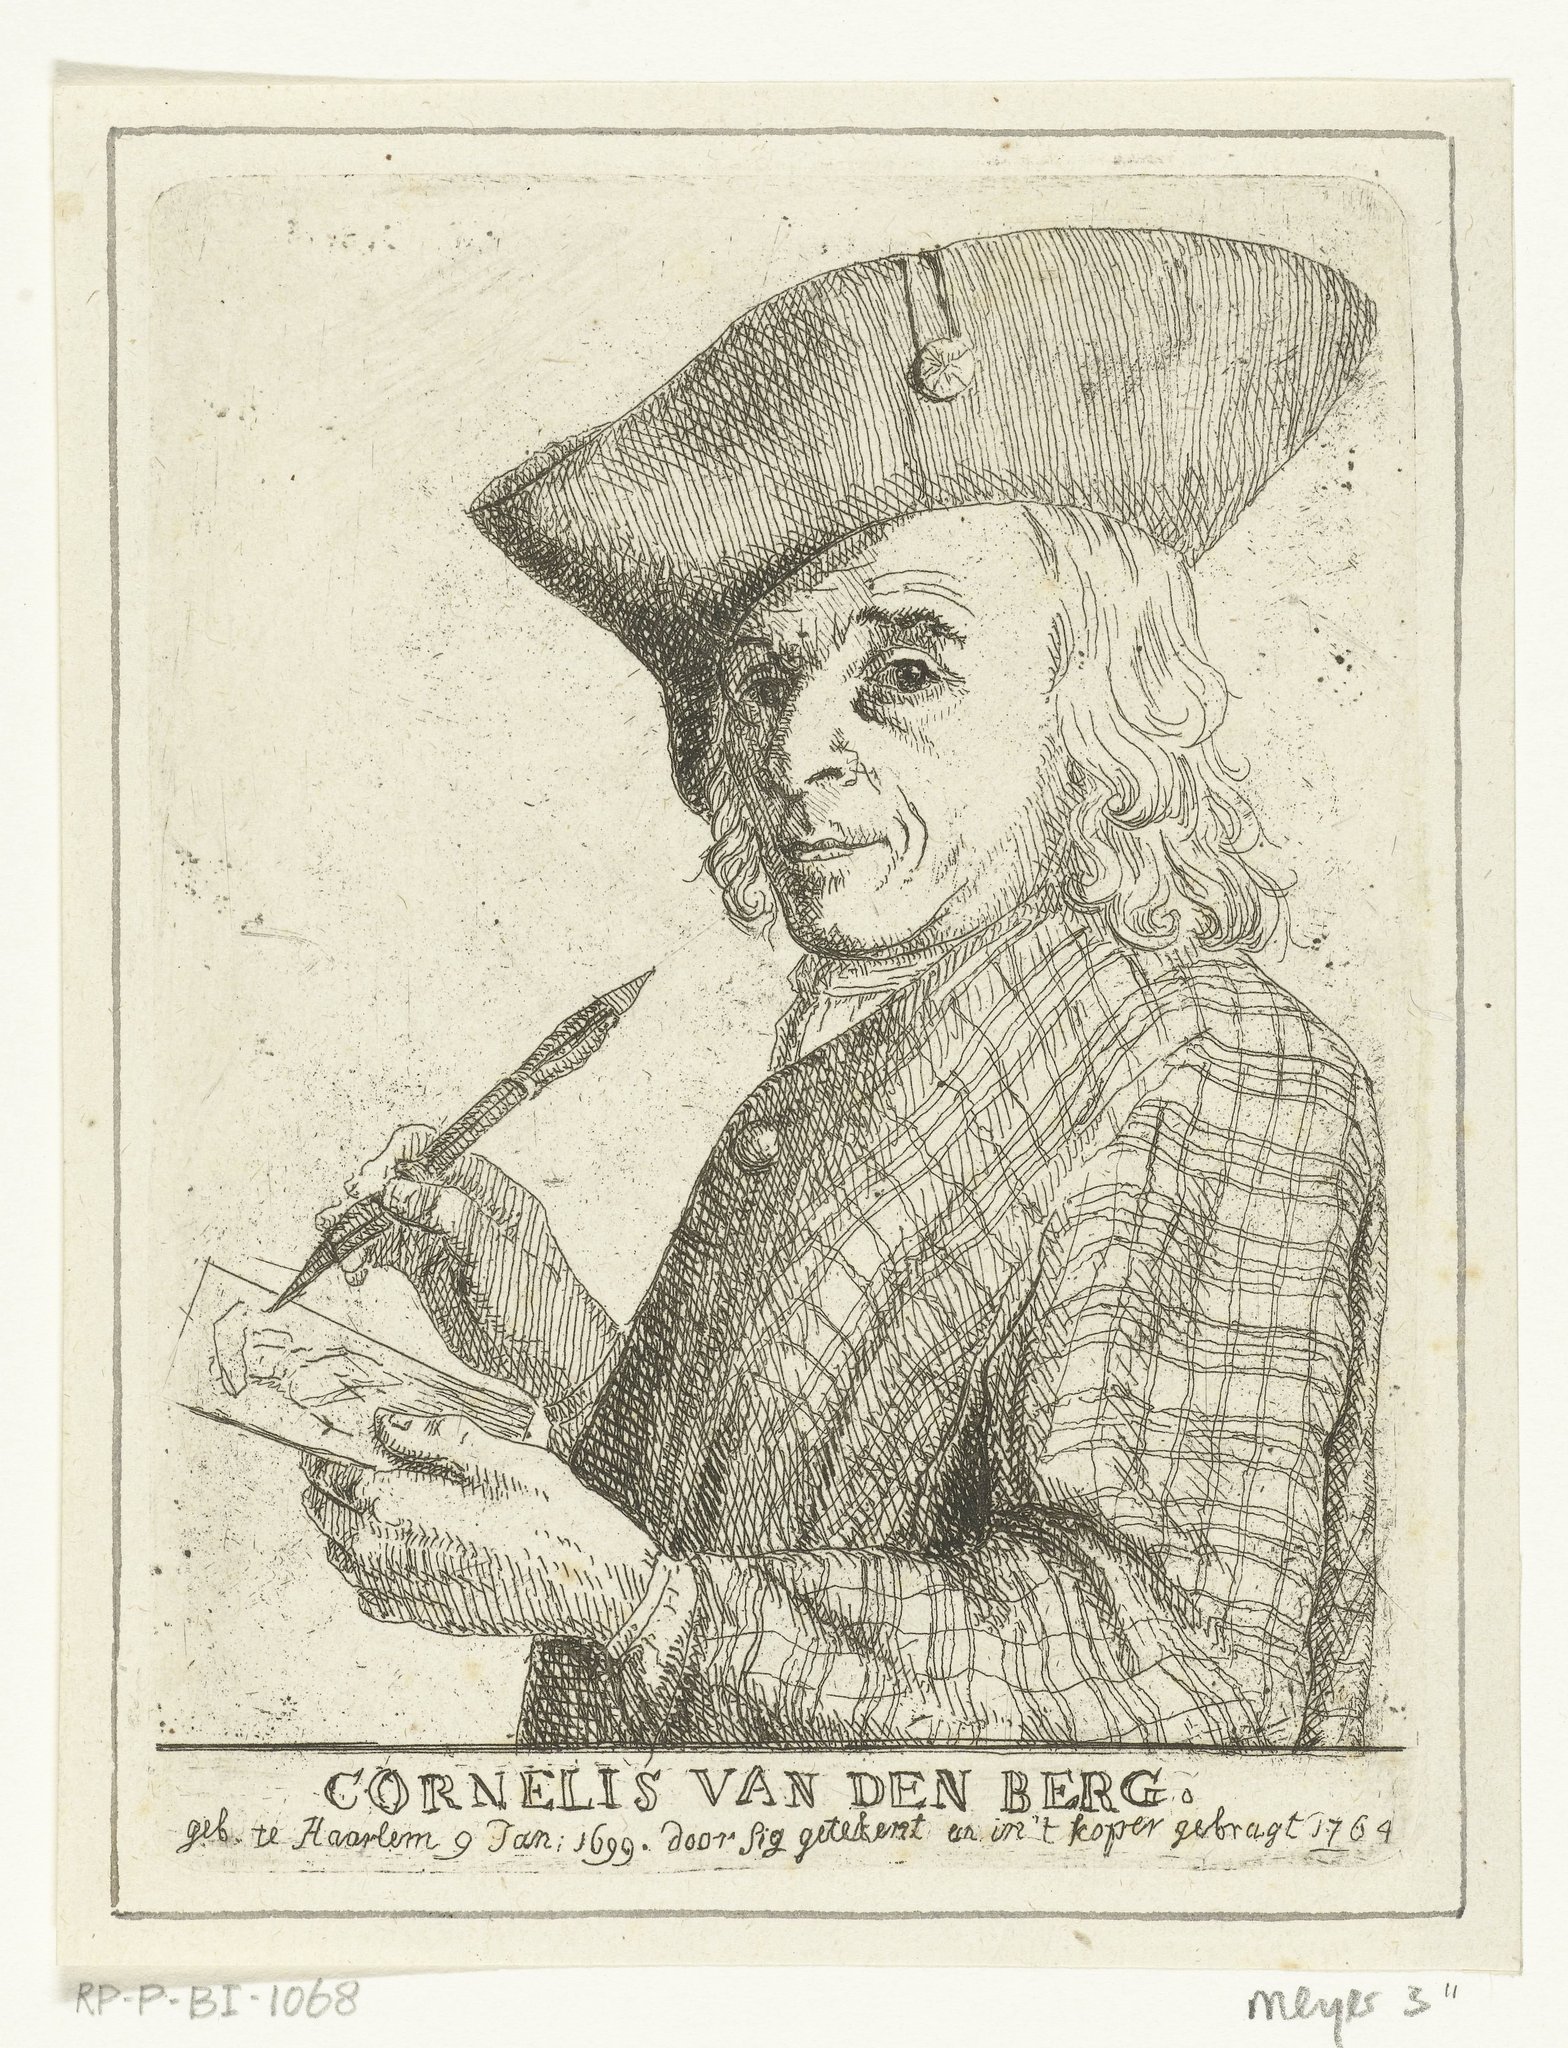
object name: print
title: Zelfportret met pen en tekening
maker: cornelis van den berg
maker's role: draughtsman, print maker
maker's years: 1699-1774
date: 1764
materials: paper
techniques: etching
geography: haarlem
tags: haarlem, print maker, draughtsman, cornelis van den berg, portrait, self-portrait of graphic artist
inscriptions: collector's mark: Lugt 2228